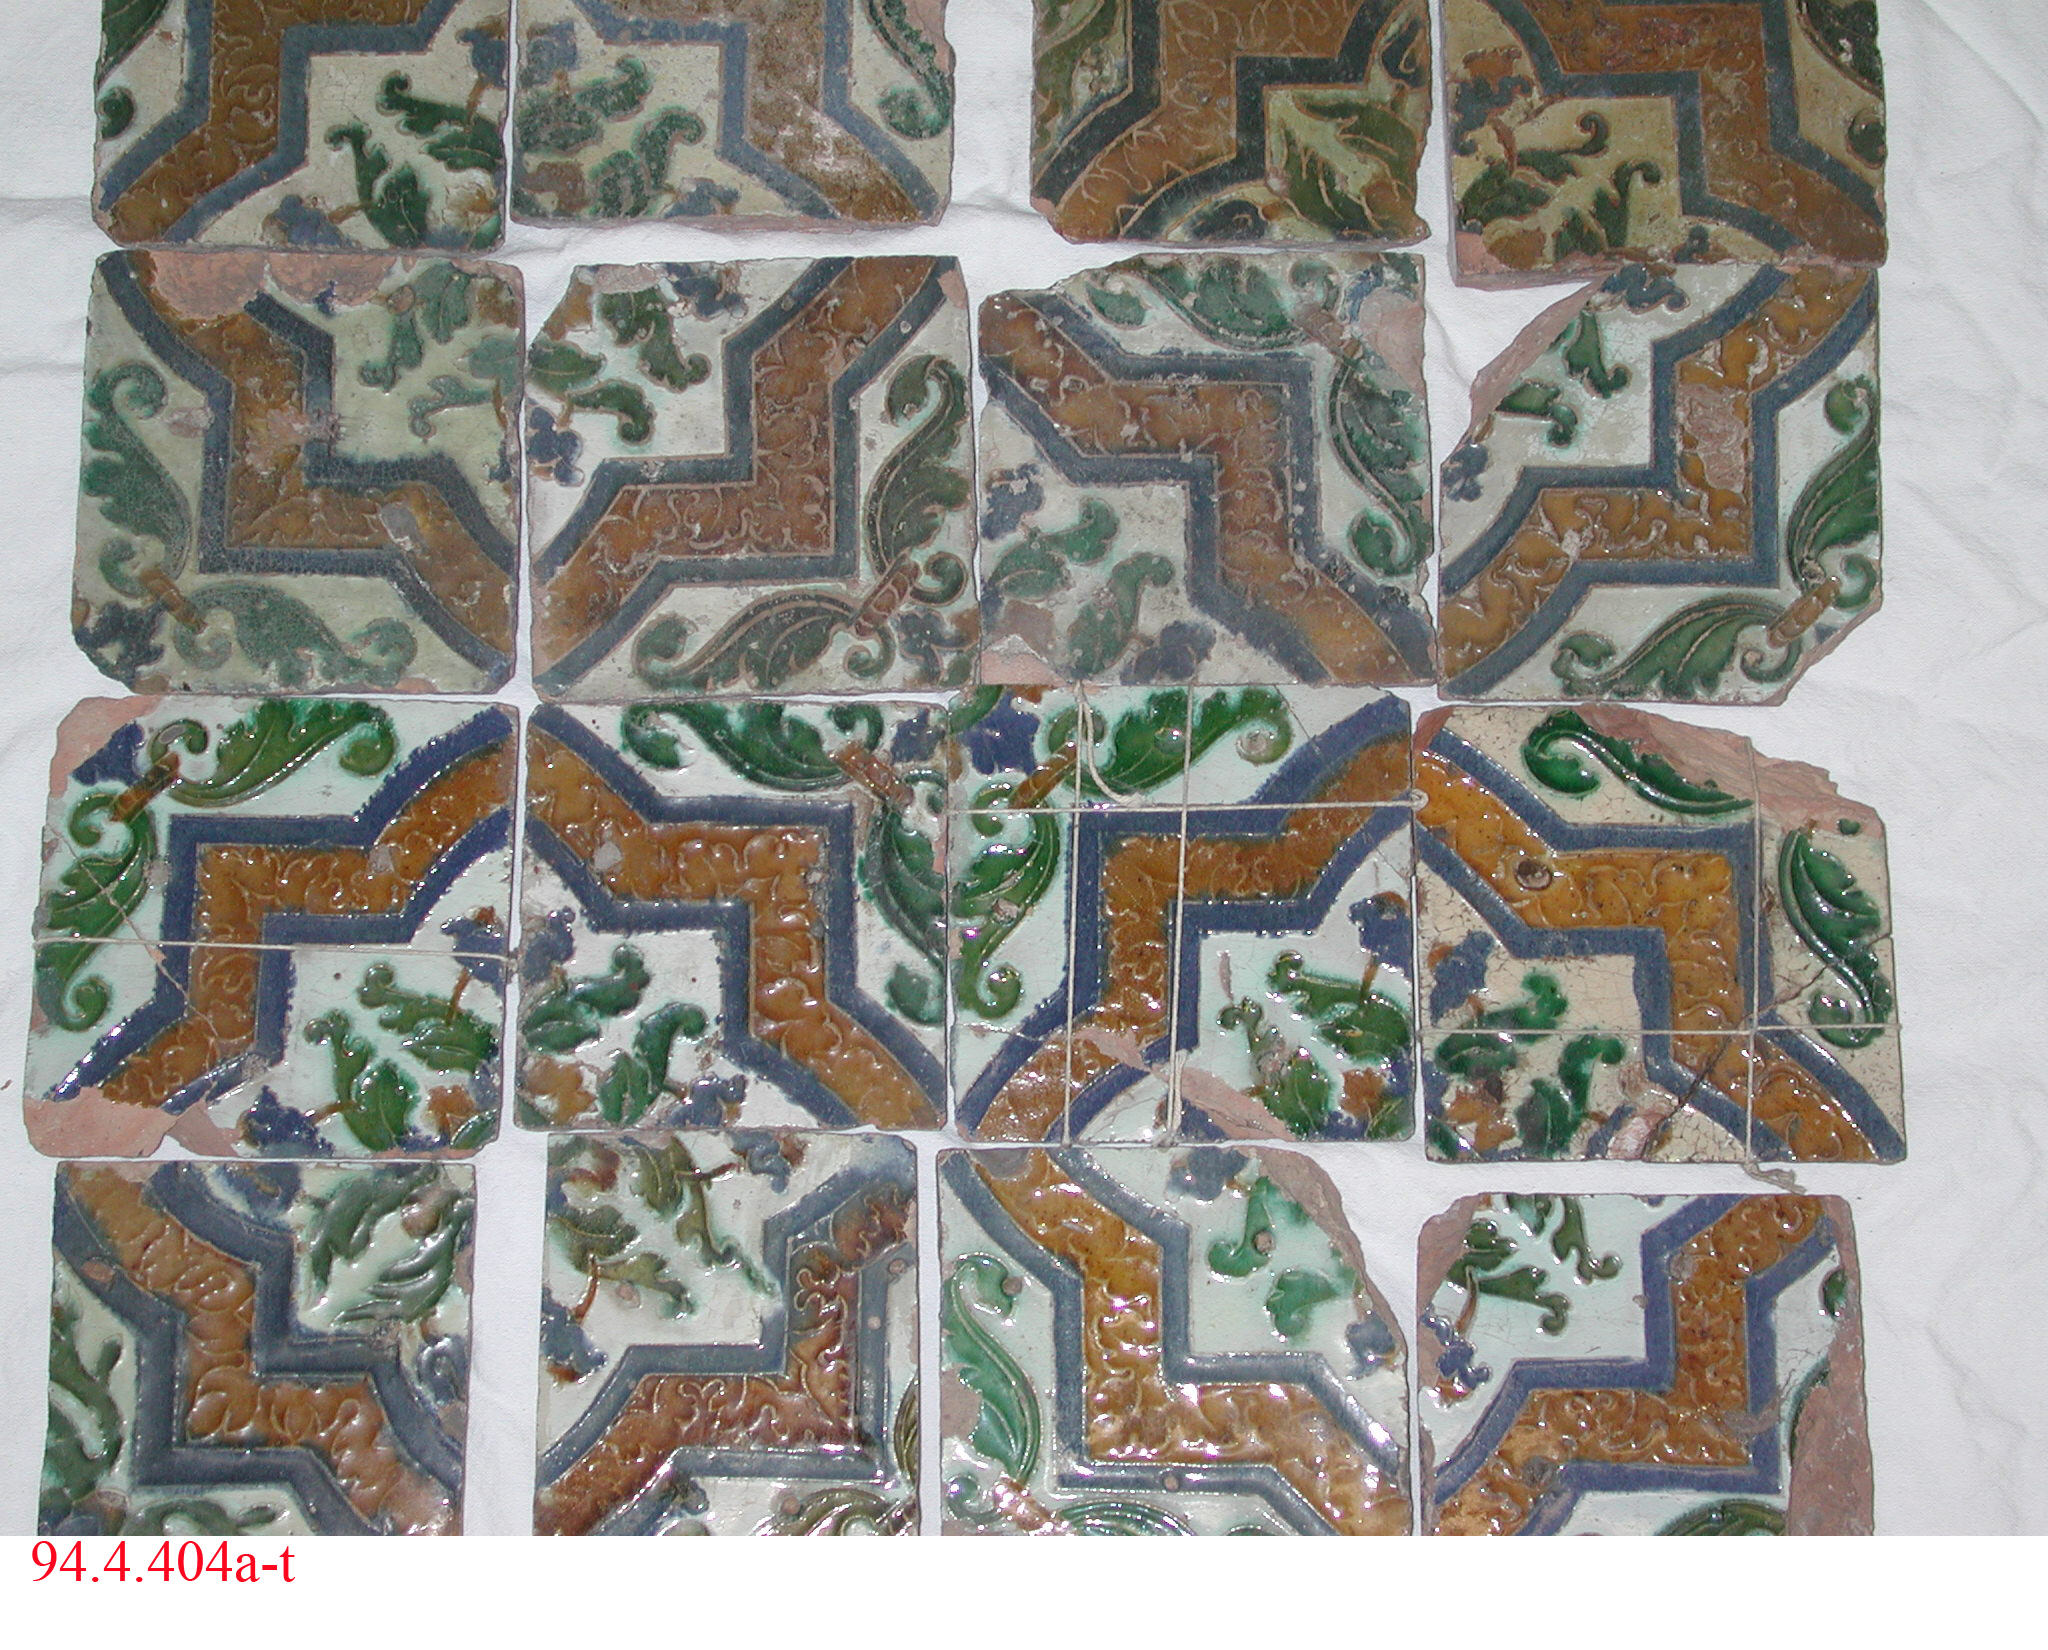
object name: tile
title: Tiles (20)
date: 1501-1700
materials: earthenware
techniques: glazing